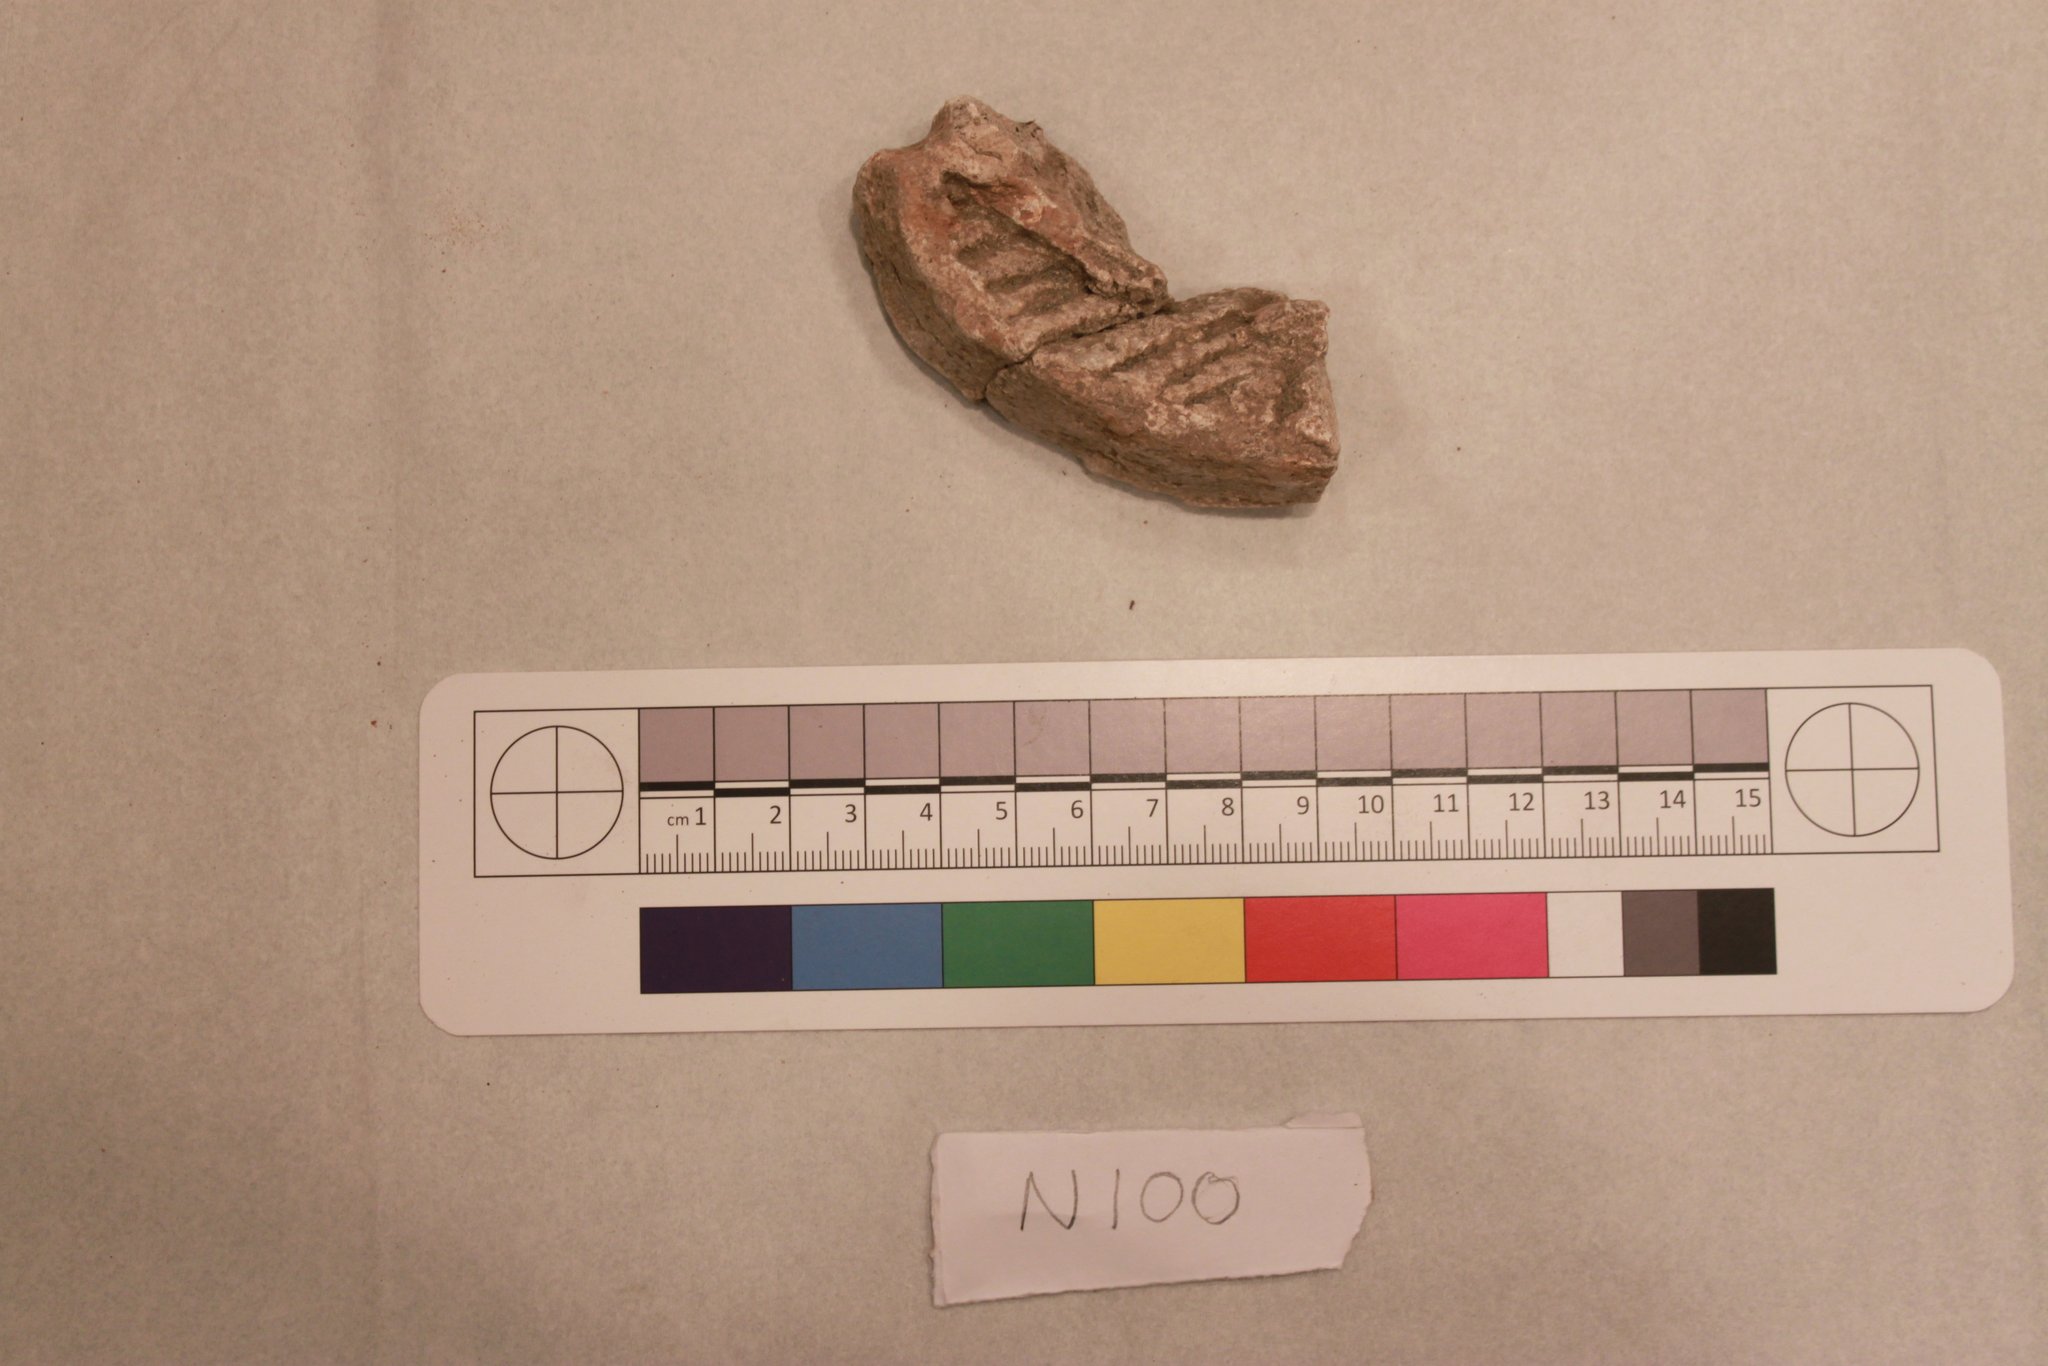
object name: fragment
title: Stucco Fragment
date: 701-1200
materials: plaster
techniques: carving, painting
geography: iran